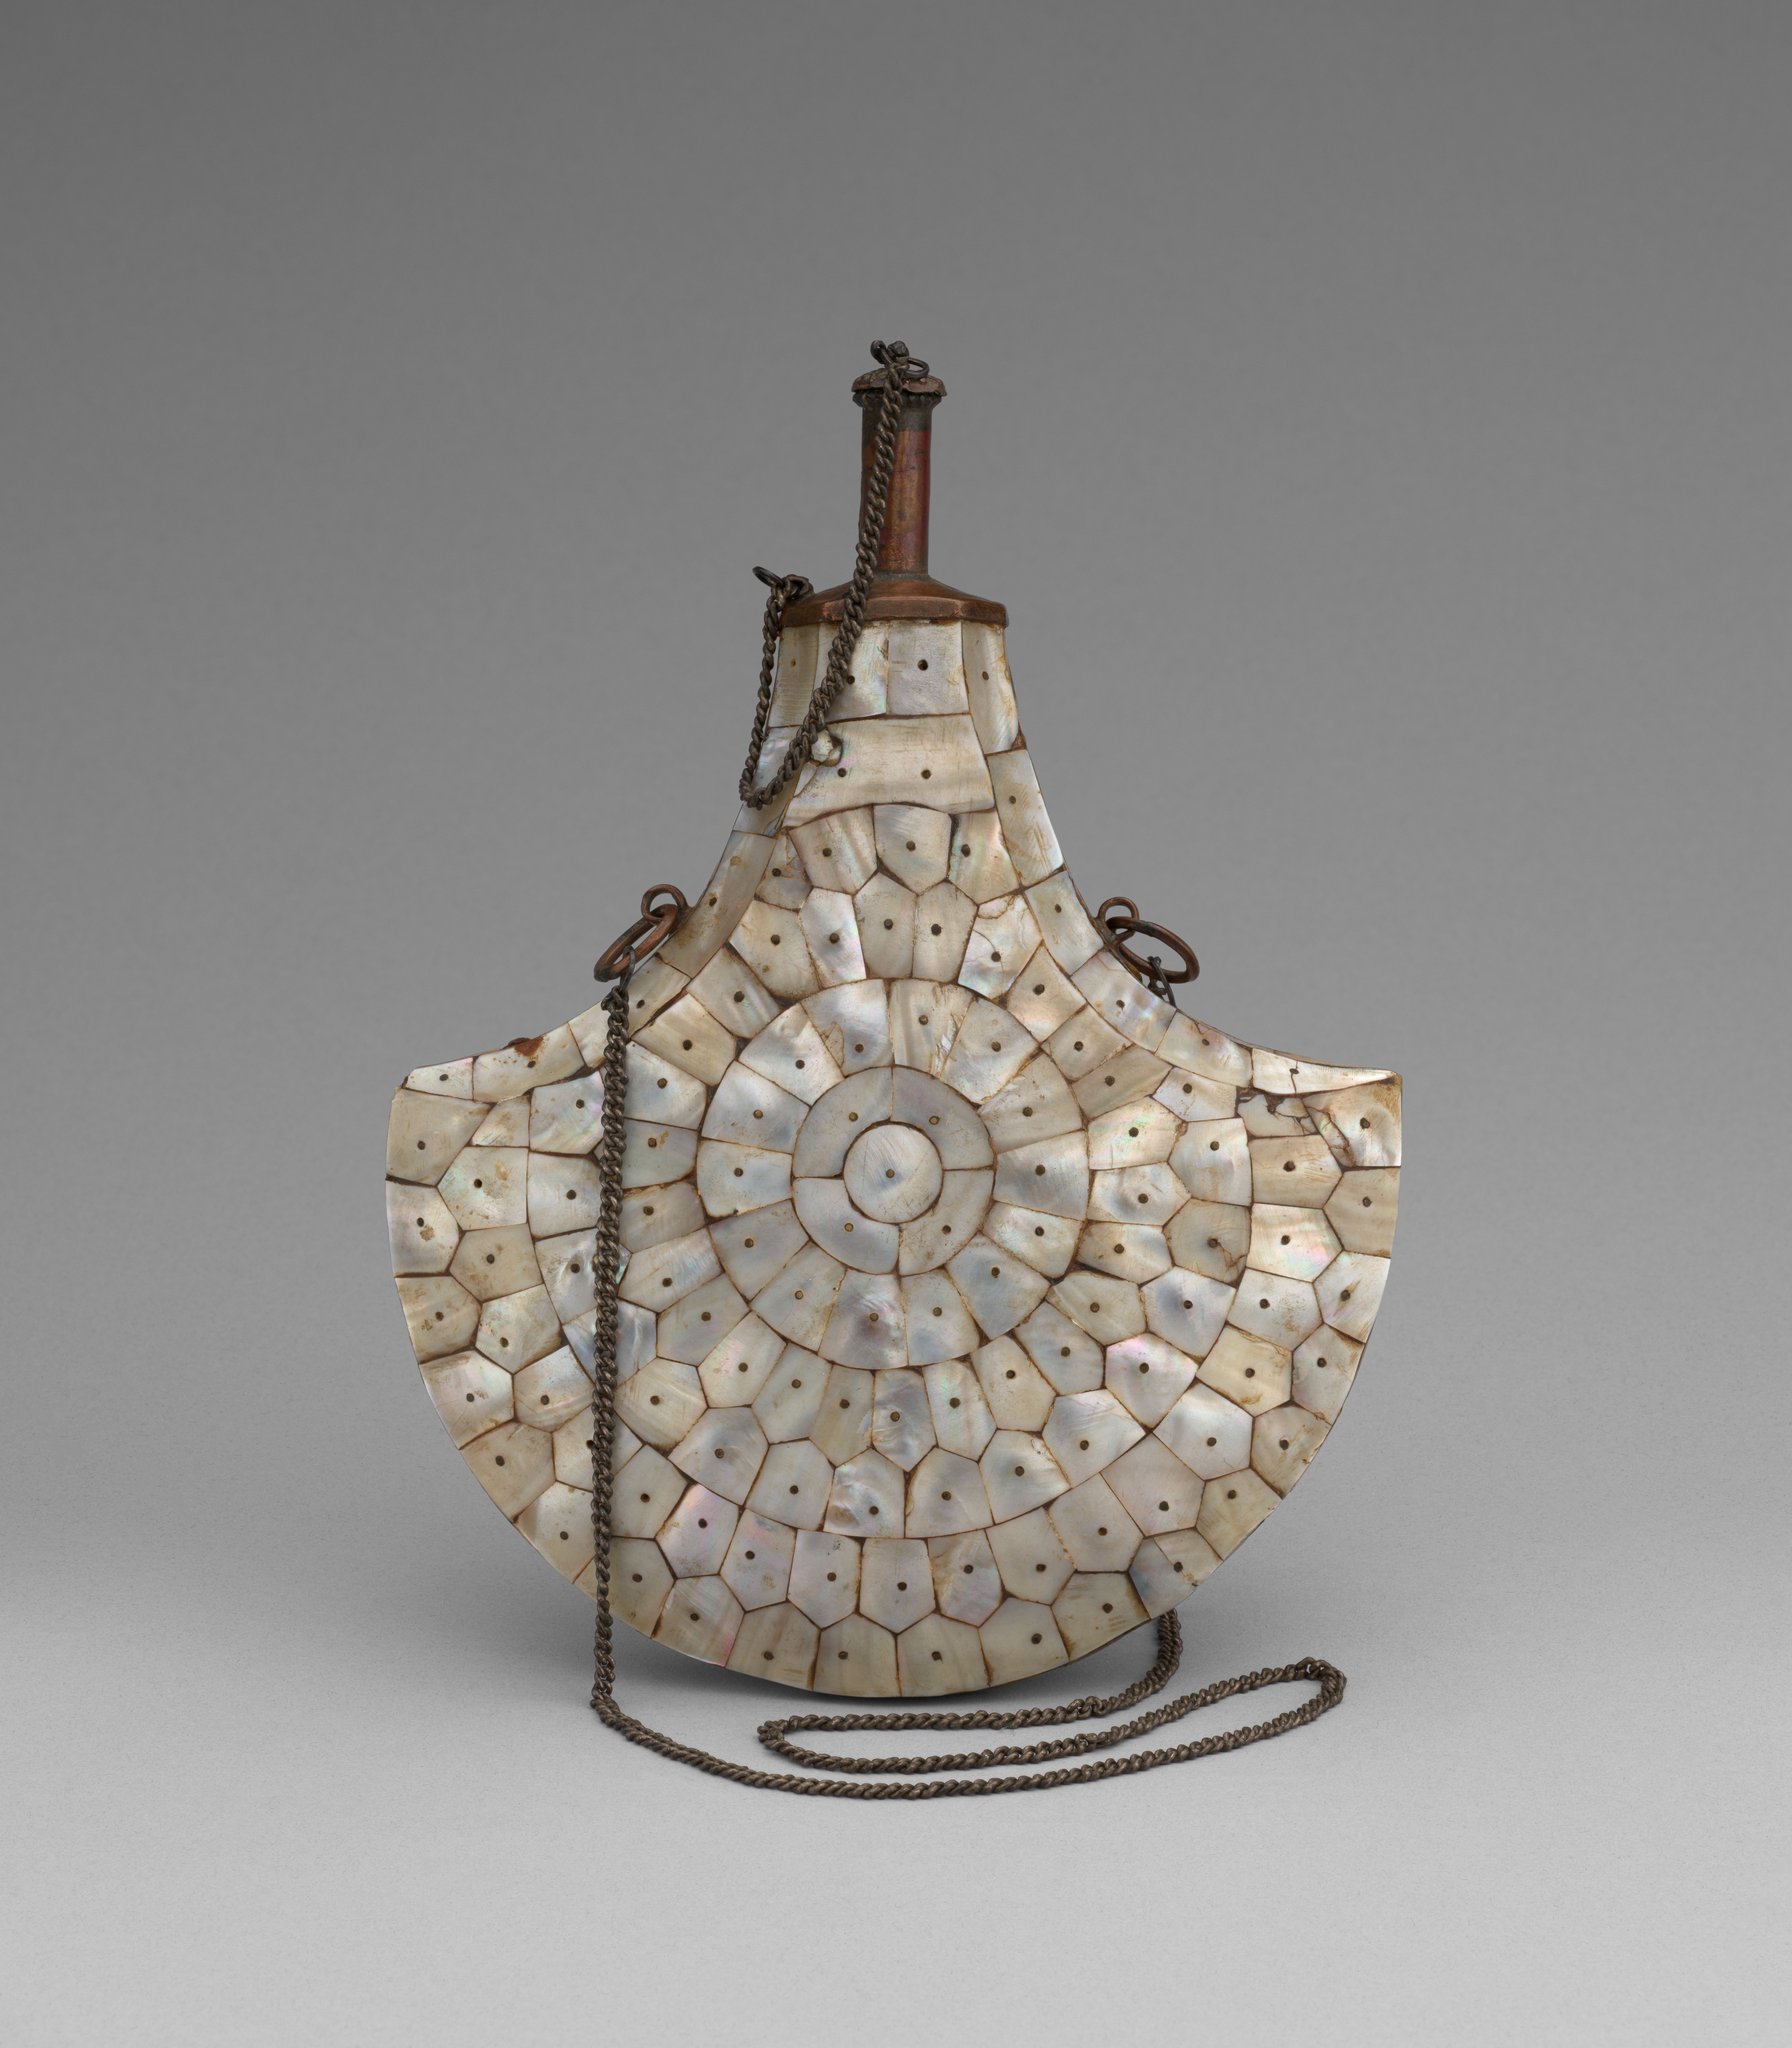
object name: powder flask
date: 1701-1900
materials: copper, metal, shell